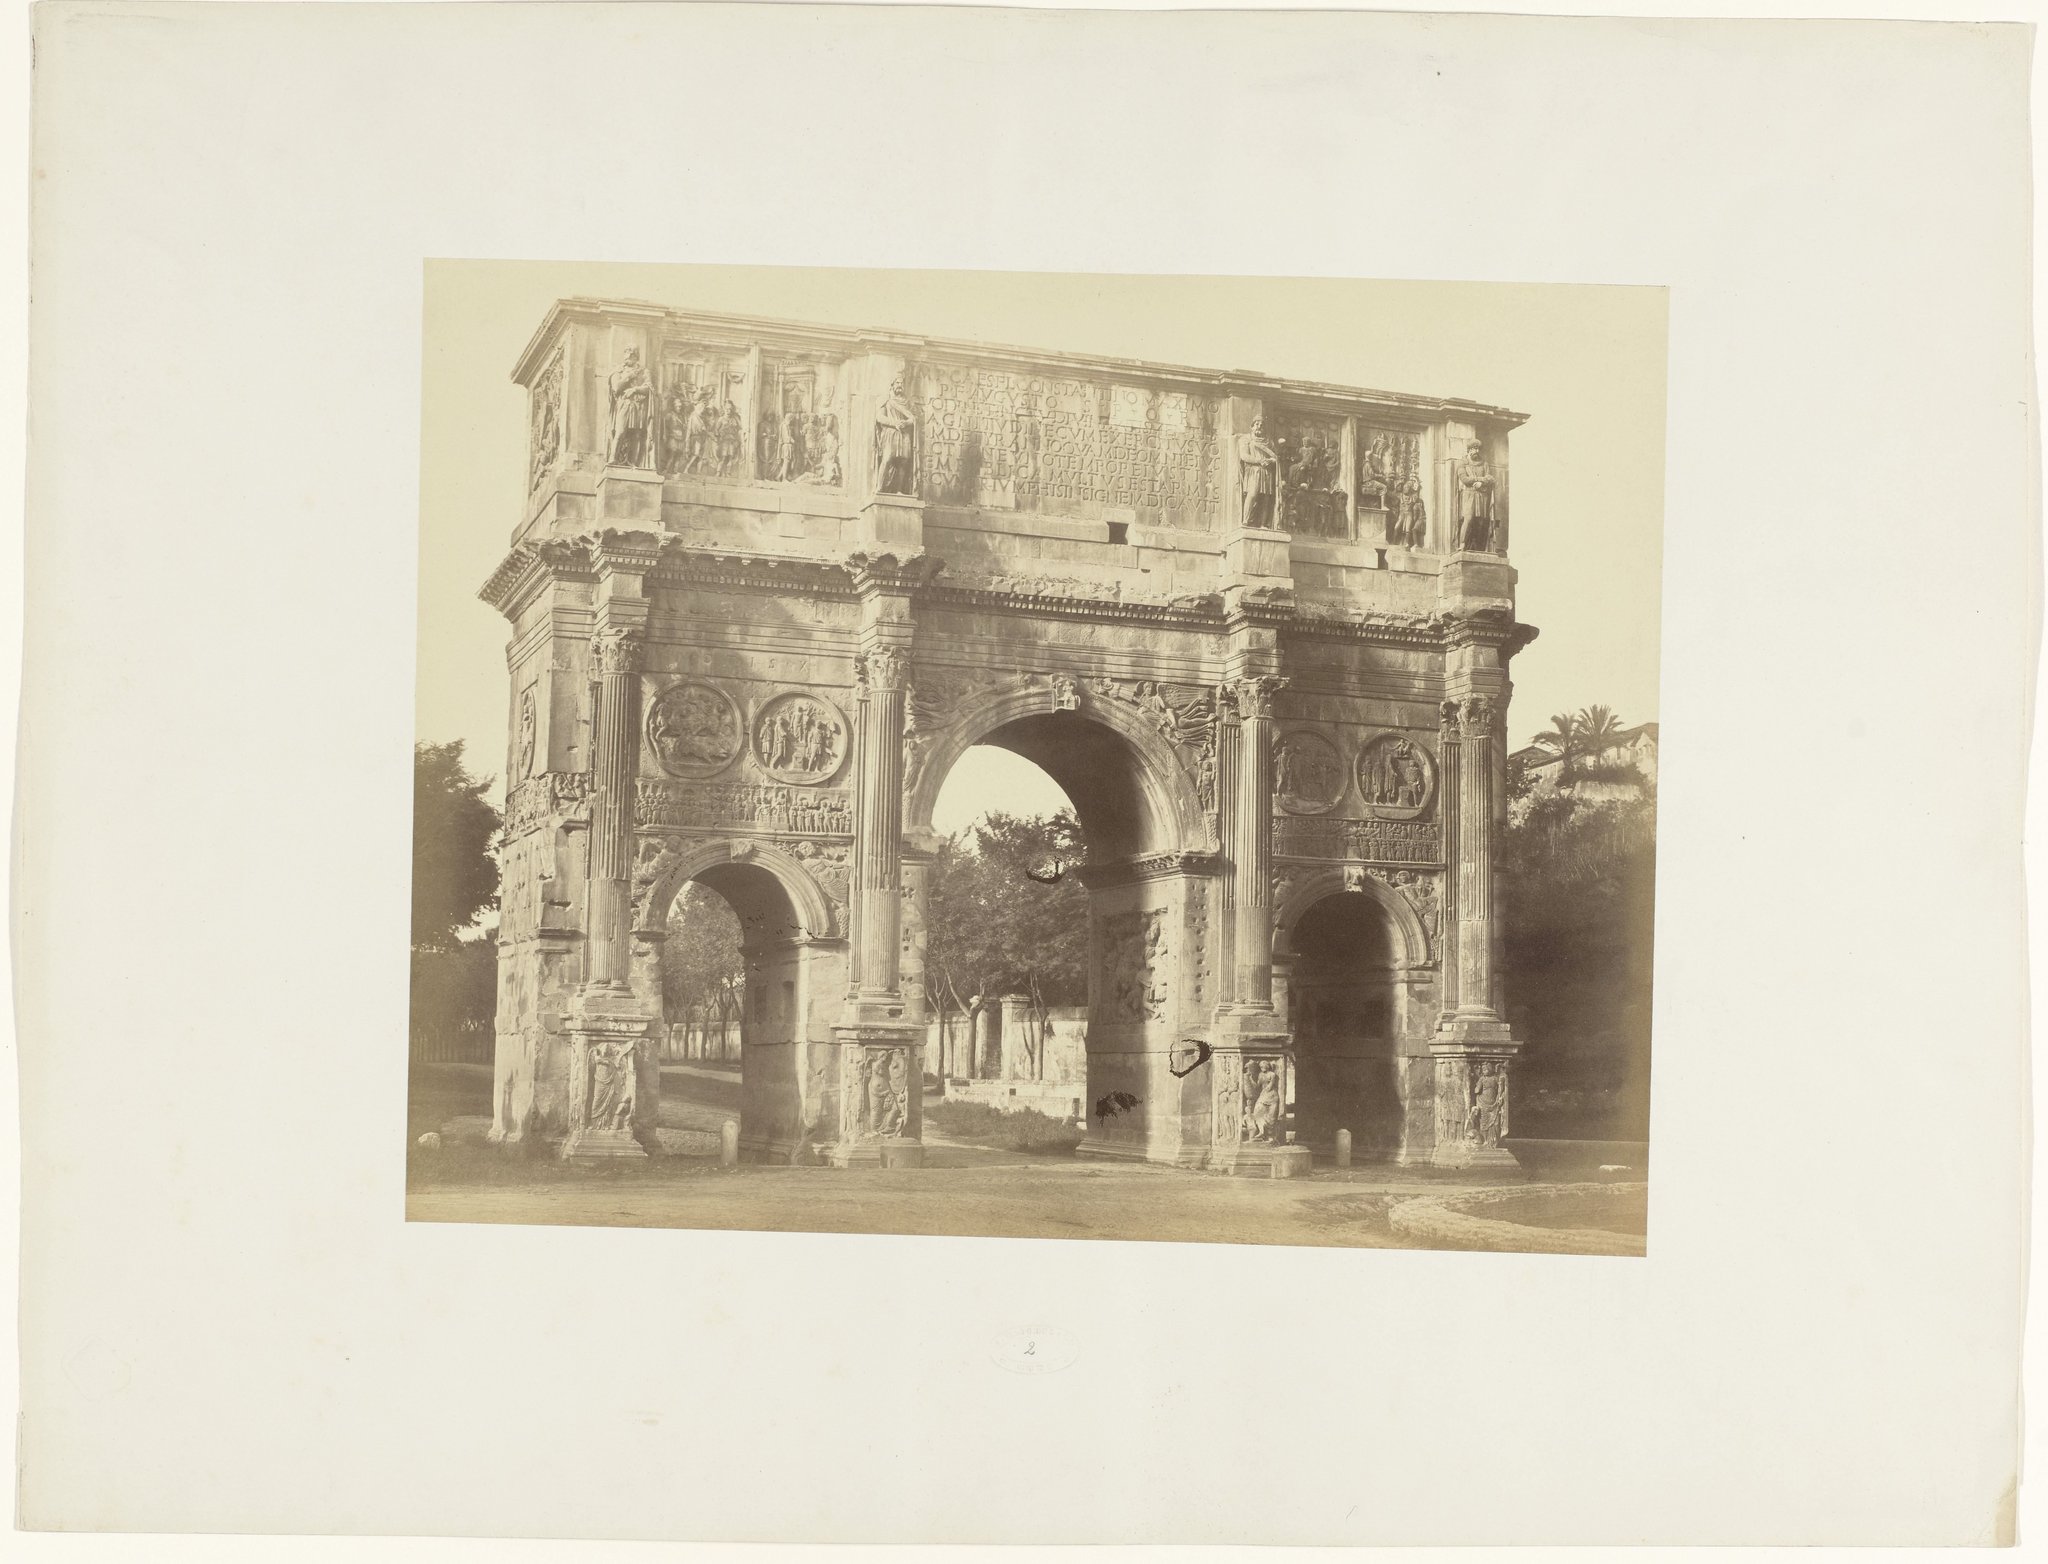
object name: photograph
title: Boog van Constantijn in Rome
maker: robert macpherson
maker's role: fotograaf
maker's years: 1814-1872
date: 1855-1870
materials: cardboard, paper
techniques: albumen print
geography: rome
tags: triumphal arch, arch of constantine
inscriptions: number: ‘2’, check stamp: ‘R. Macpherson/ Rome’